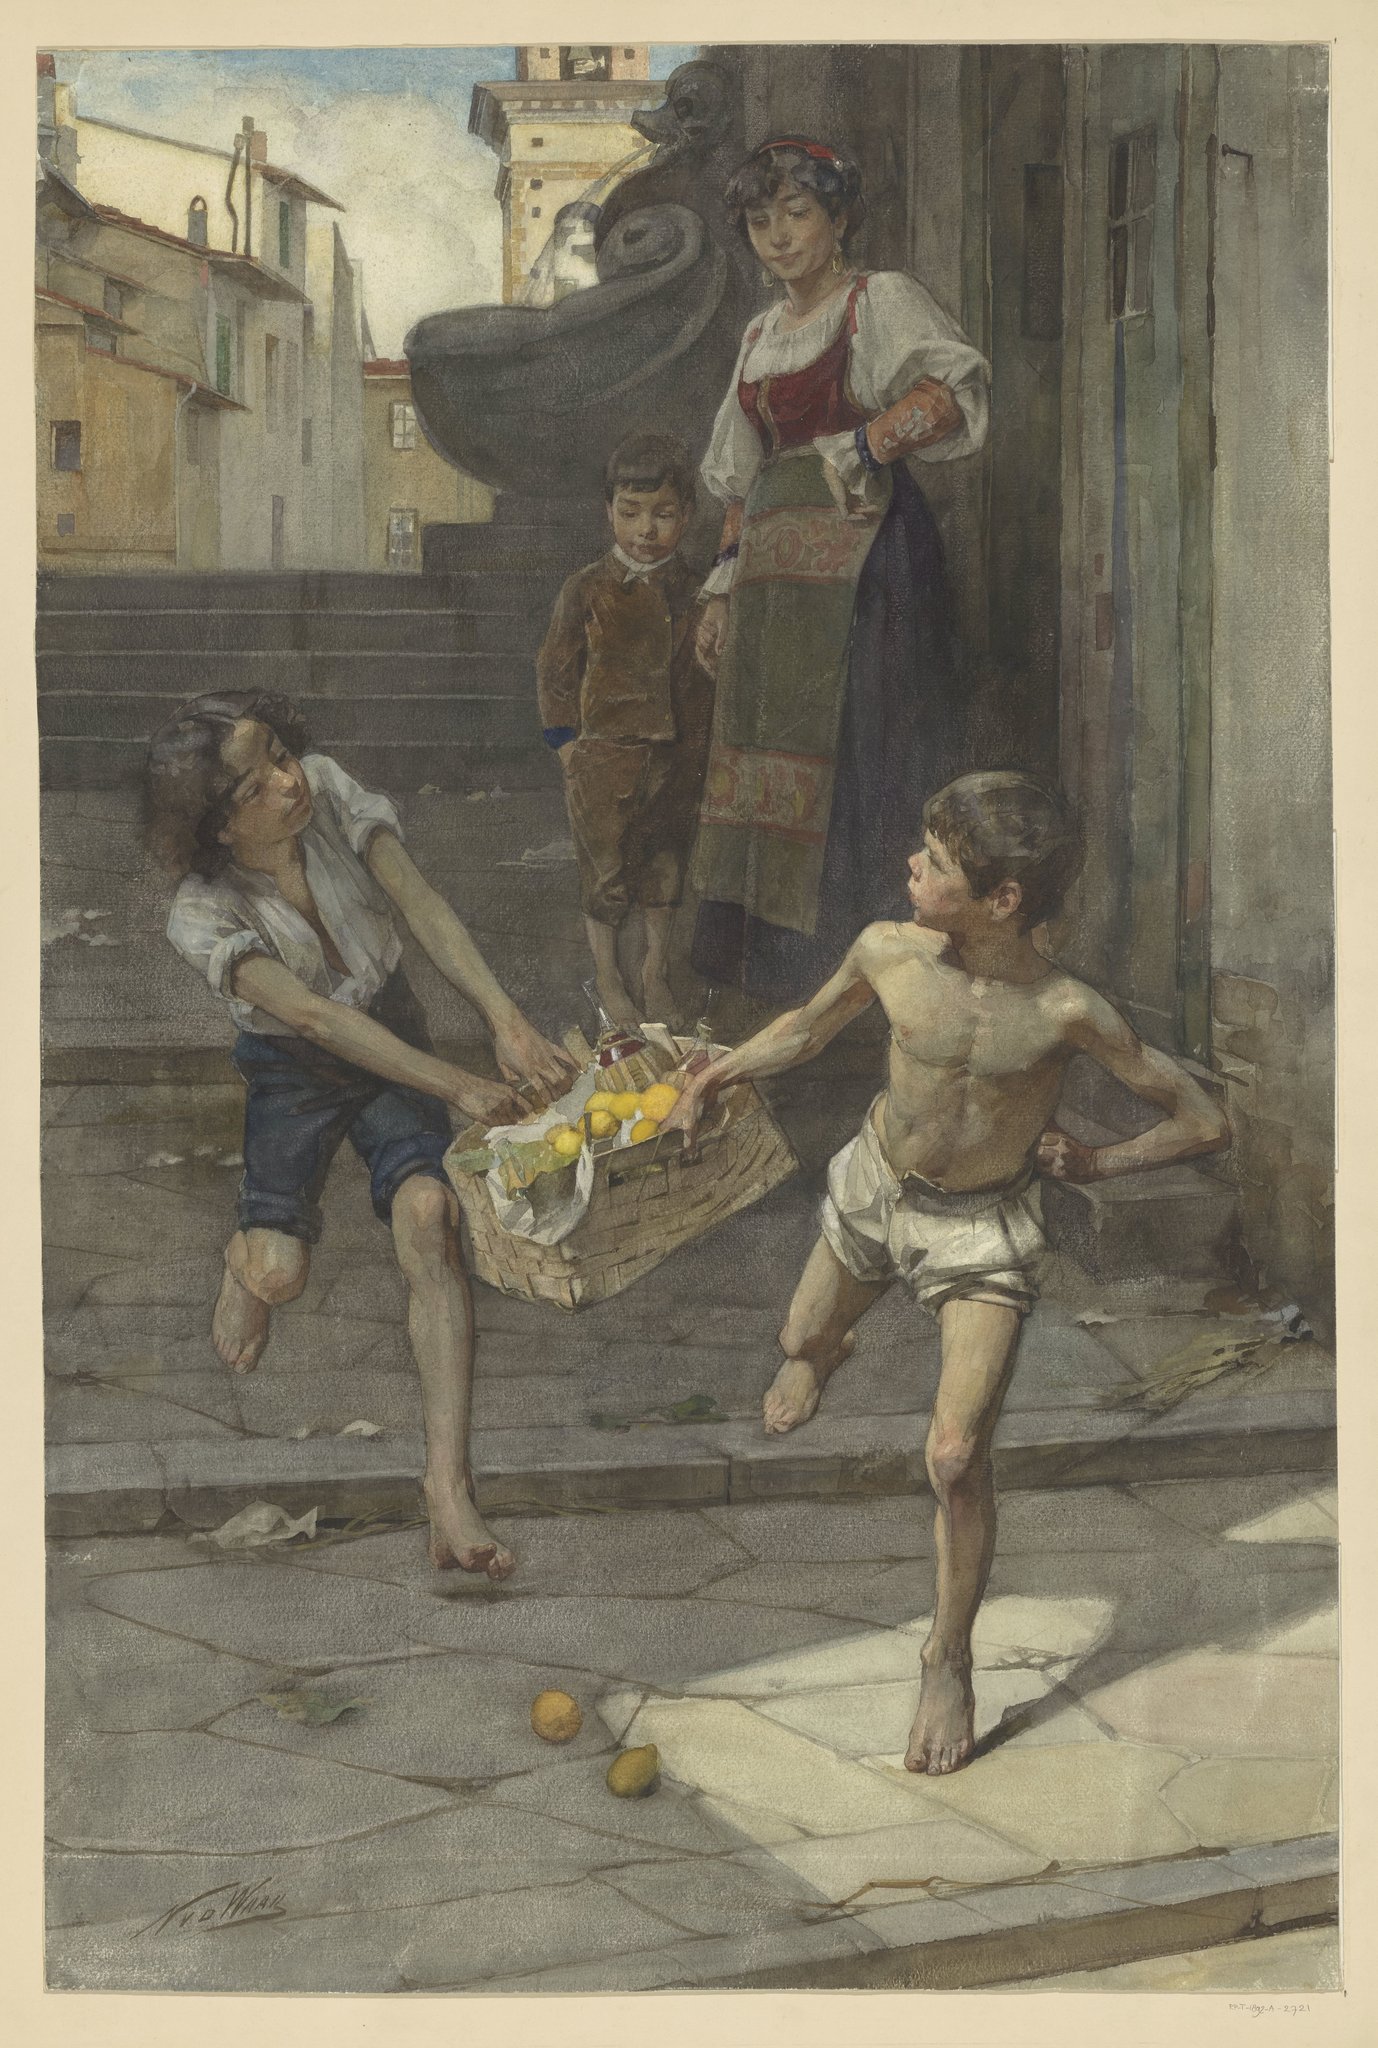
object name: drawing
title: Straatscène in een Italiaanse stad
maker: nicolaas van der waay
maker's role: draughtsman, painter, print maker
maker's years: 1855-1936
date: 1865-1892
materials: paper, watercolor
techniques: brush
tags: street, italy